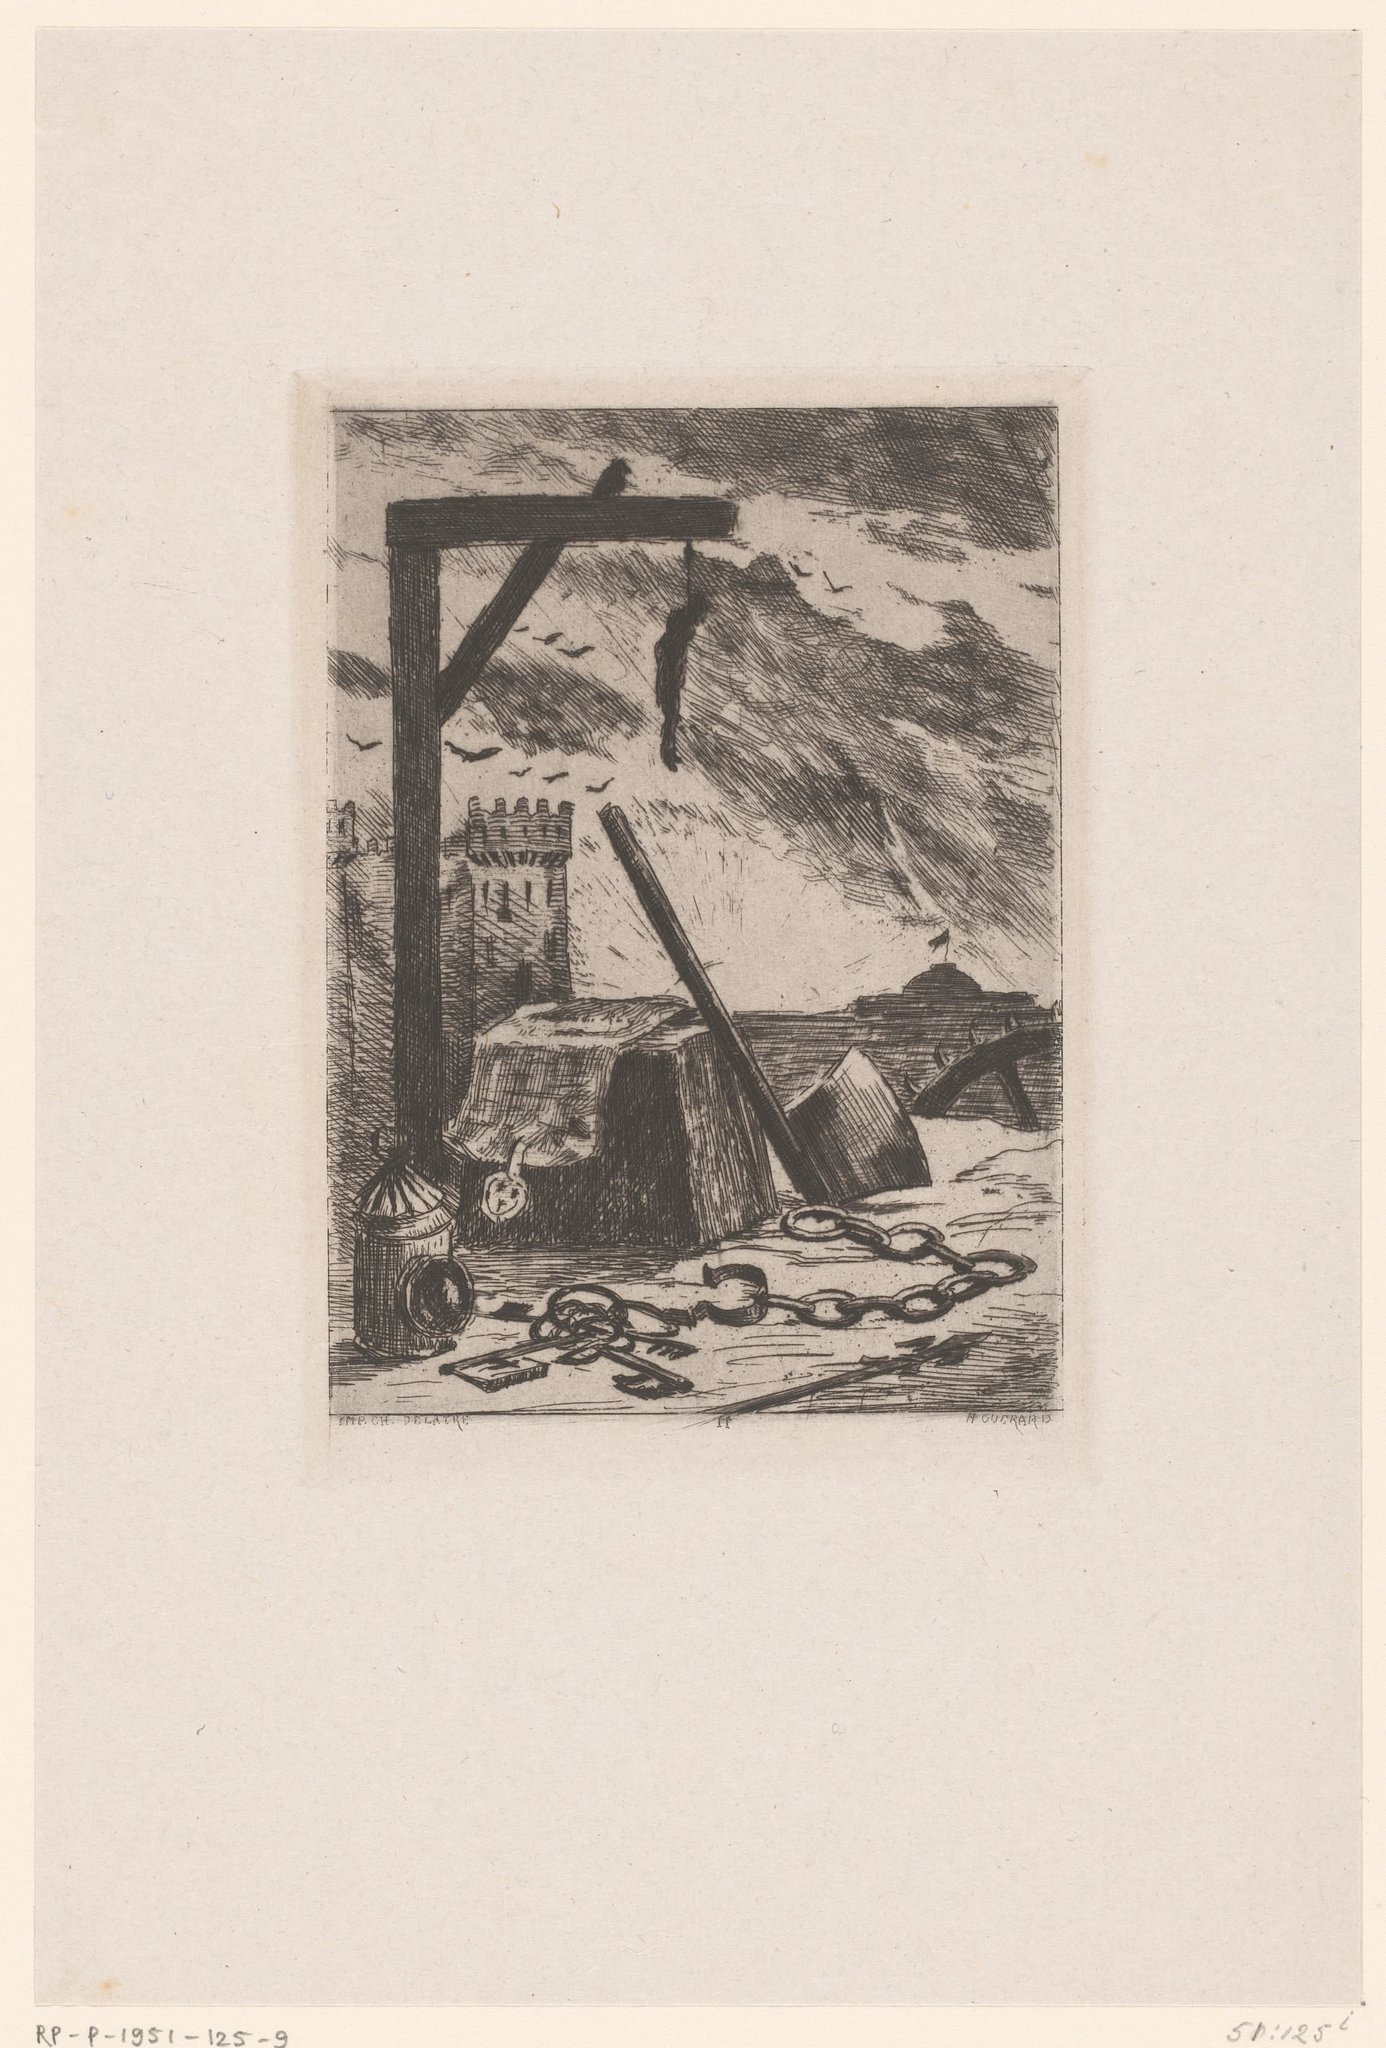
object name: print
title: Illustraties bij Les Châtiments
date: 1856-1897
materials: paper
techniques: etching, intaglio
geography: paris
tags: instruments of torture, execution or punishment: gallows, illustration ~ printed matter, book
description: Maakt deel uit van een tiendelige serie met illustraties bij de dichtbundel 'Les Châtiments' (1853) door Victor Hugo. De tekst werd wegens een anti-napoleontisch sentiment in Frankrijk verboden. Daarom werd de serie in de eerste instantie in Brussel uitgegeven. Deze editie werd echter in Parijs gepubliceerd door de Libraire Nouvelle. Op de achterzijde van de papieren omslag wordt reclame gemaakt voor een serie eveneens door Guérard met illustraties bij 'Napoléon le Petit' door Victor Hugo. De prent illustreert enkele regels uit het gedicht 'Nox'.